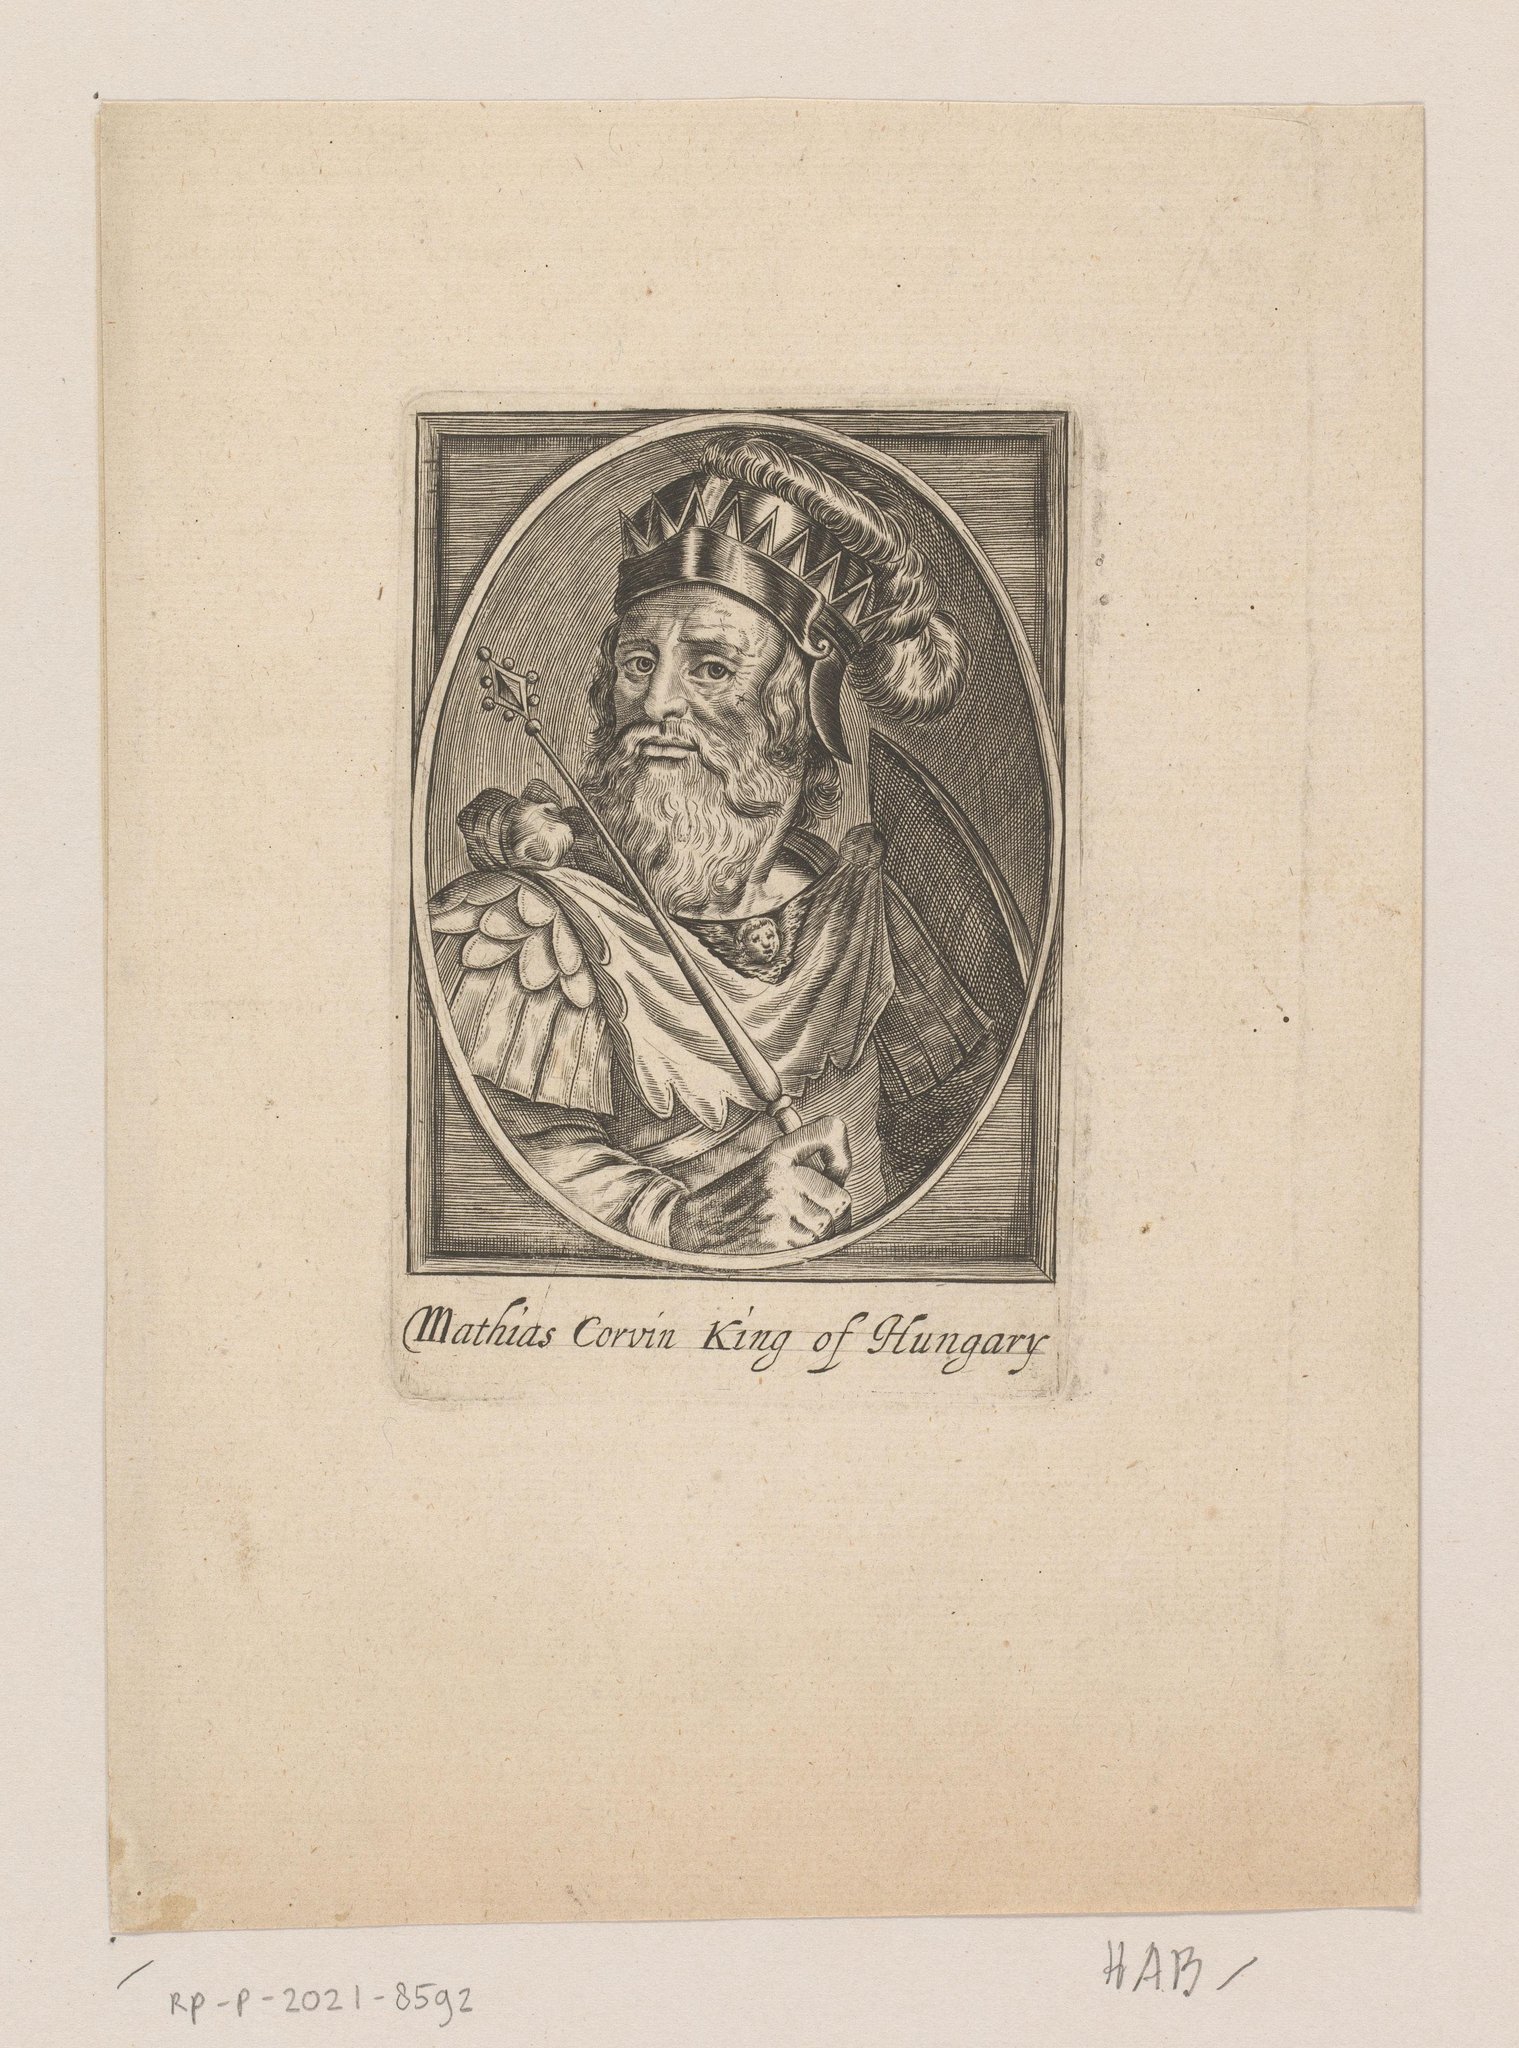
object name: print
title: Portret van Matthias Corvinus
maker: Anonymous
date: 1670-1720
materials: paper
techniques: engraving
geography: england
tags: vienna, historical persons, king